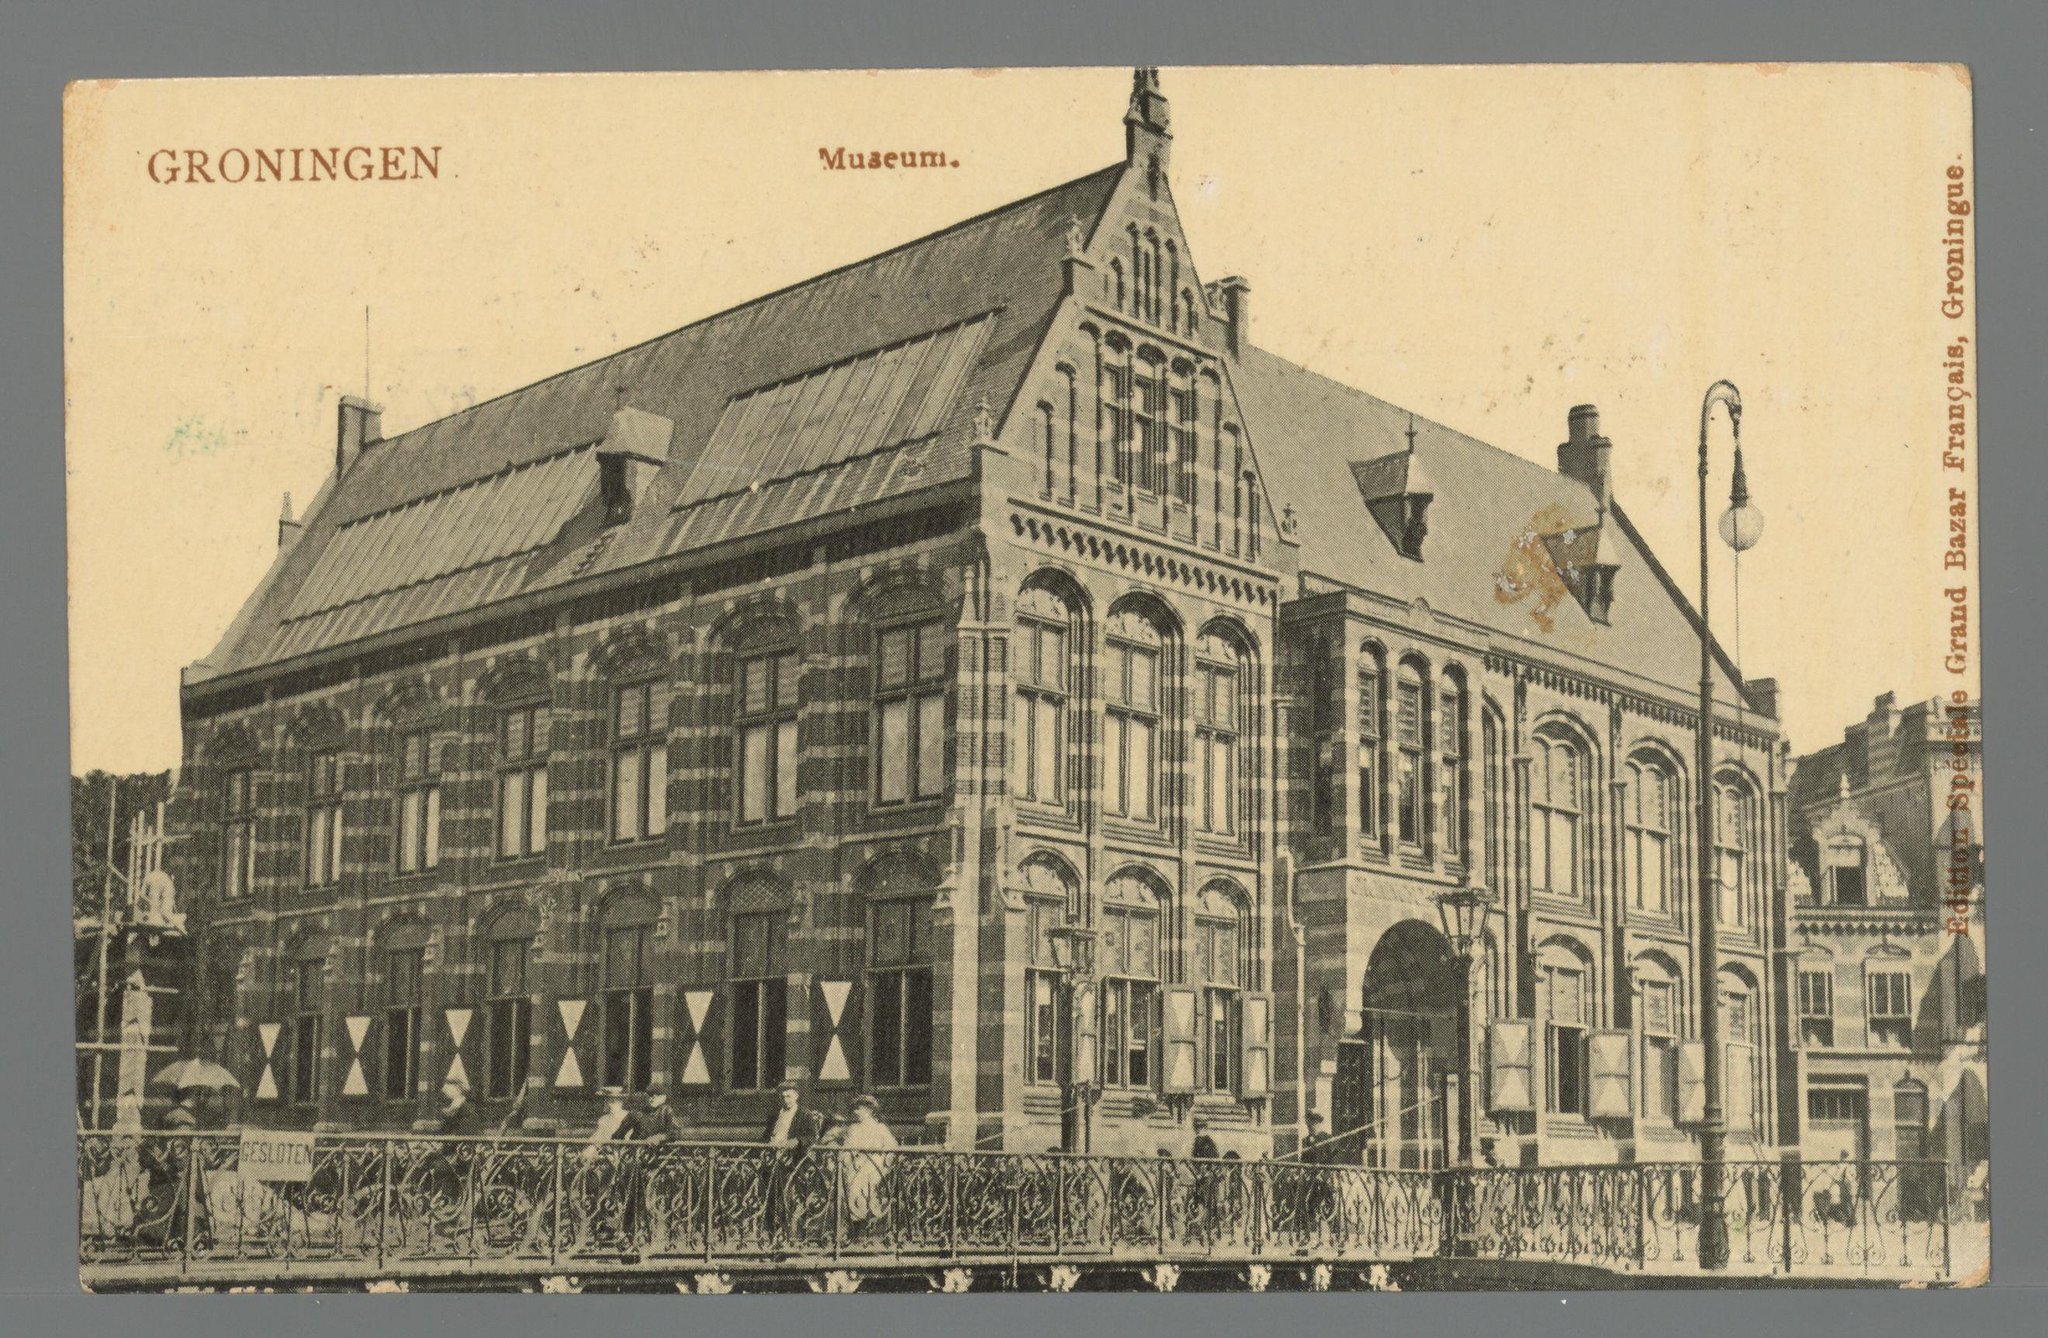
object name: photomechanical print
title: Groningen. Museum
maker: Anonymous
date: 1905-1907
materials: cardboard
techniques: writing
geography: groningen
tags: permanent exhibition, museum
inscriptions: postage stamp